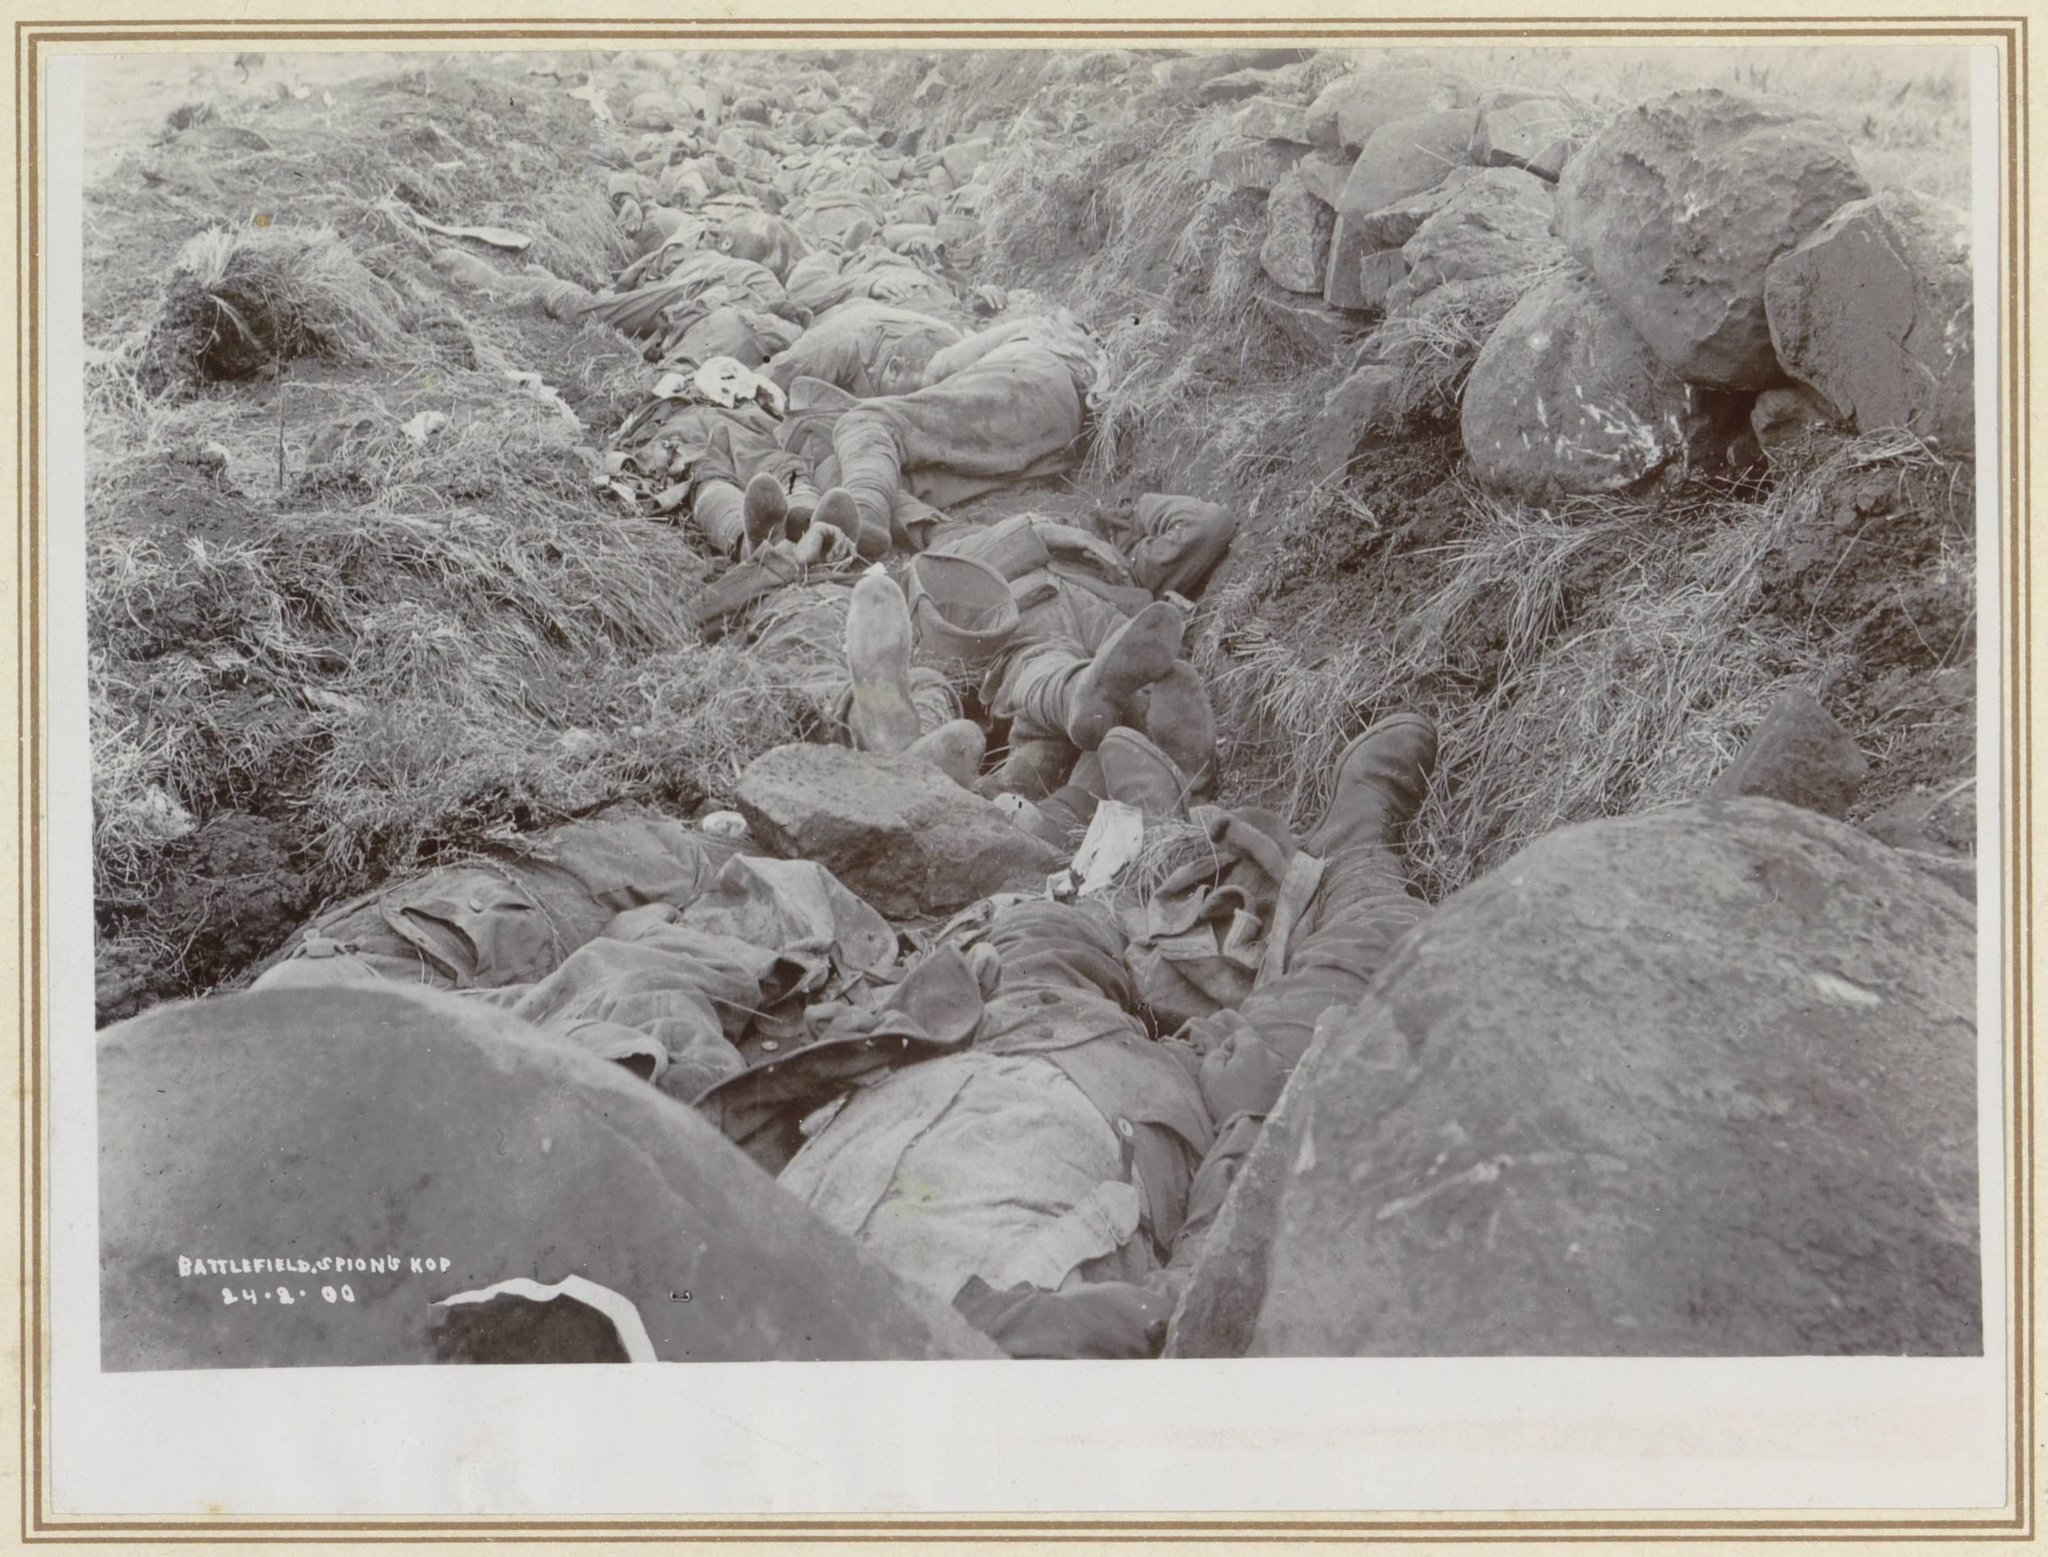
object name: album leaf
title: Battlefield. Spion's Kop 24.2.00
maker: Anonymous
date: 1900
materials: cardboard, paper, photographic support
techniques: gelatin silver print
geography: spionkop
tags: horrors of war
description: Onderdeel van Fotoalbum met opnames van de Tweede Boerenoorlog (1899-1902).